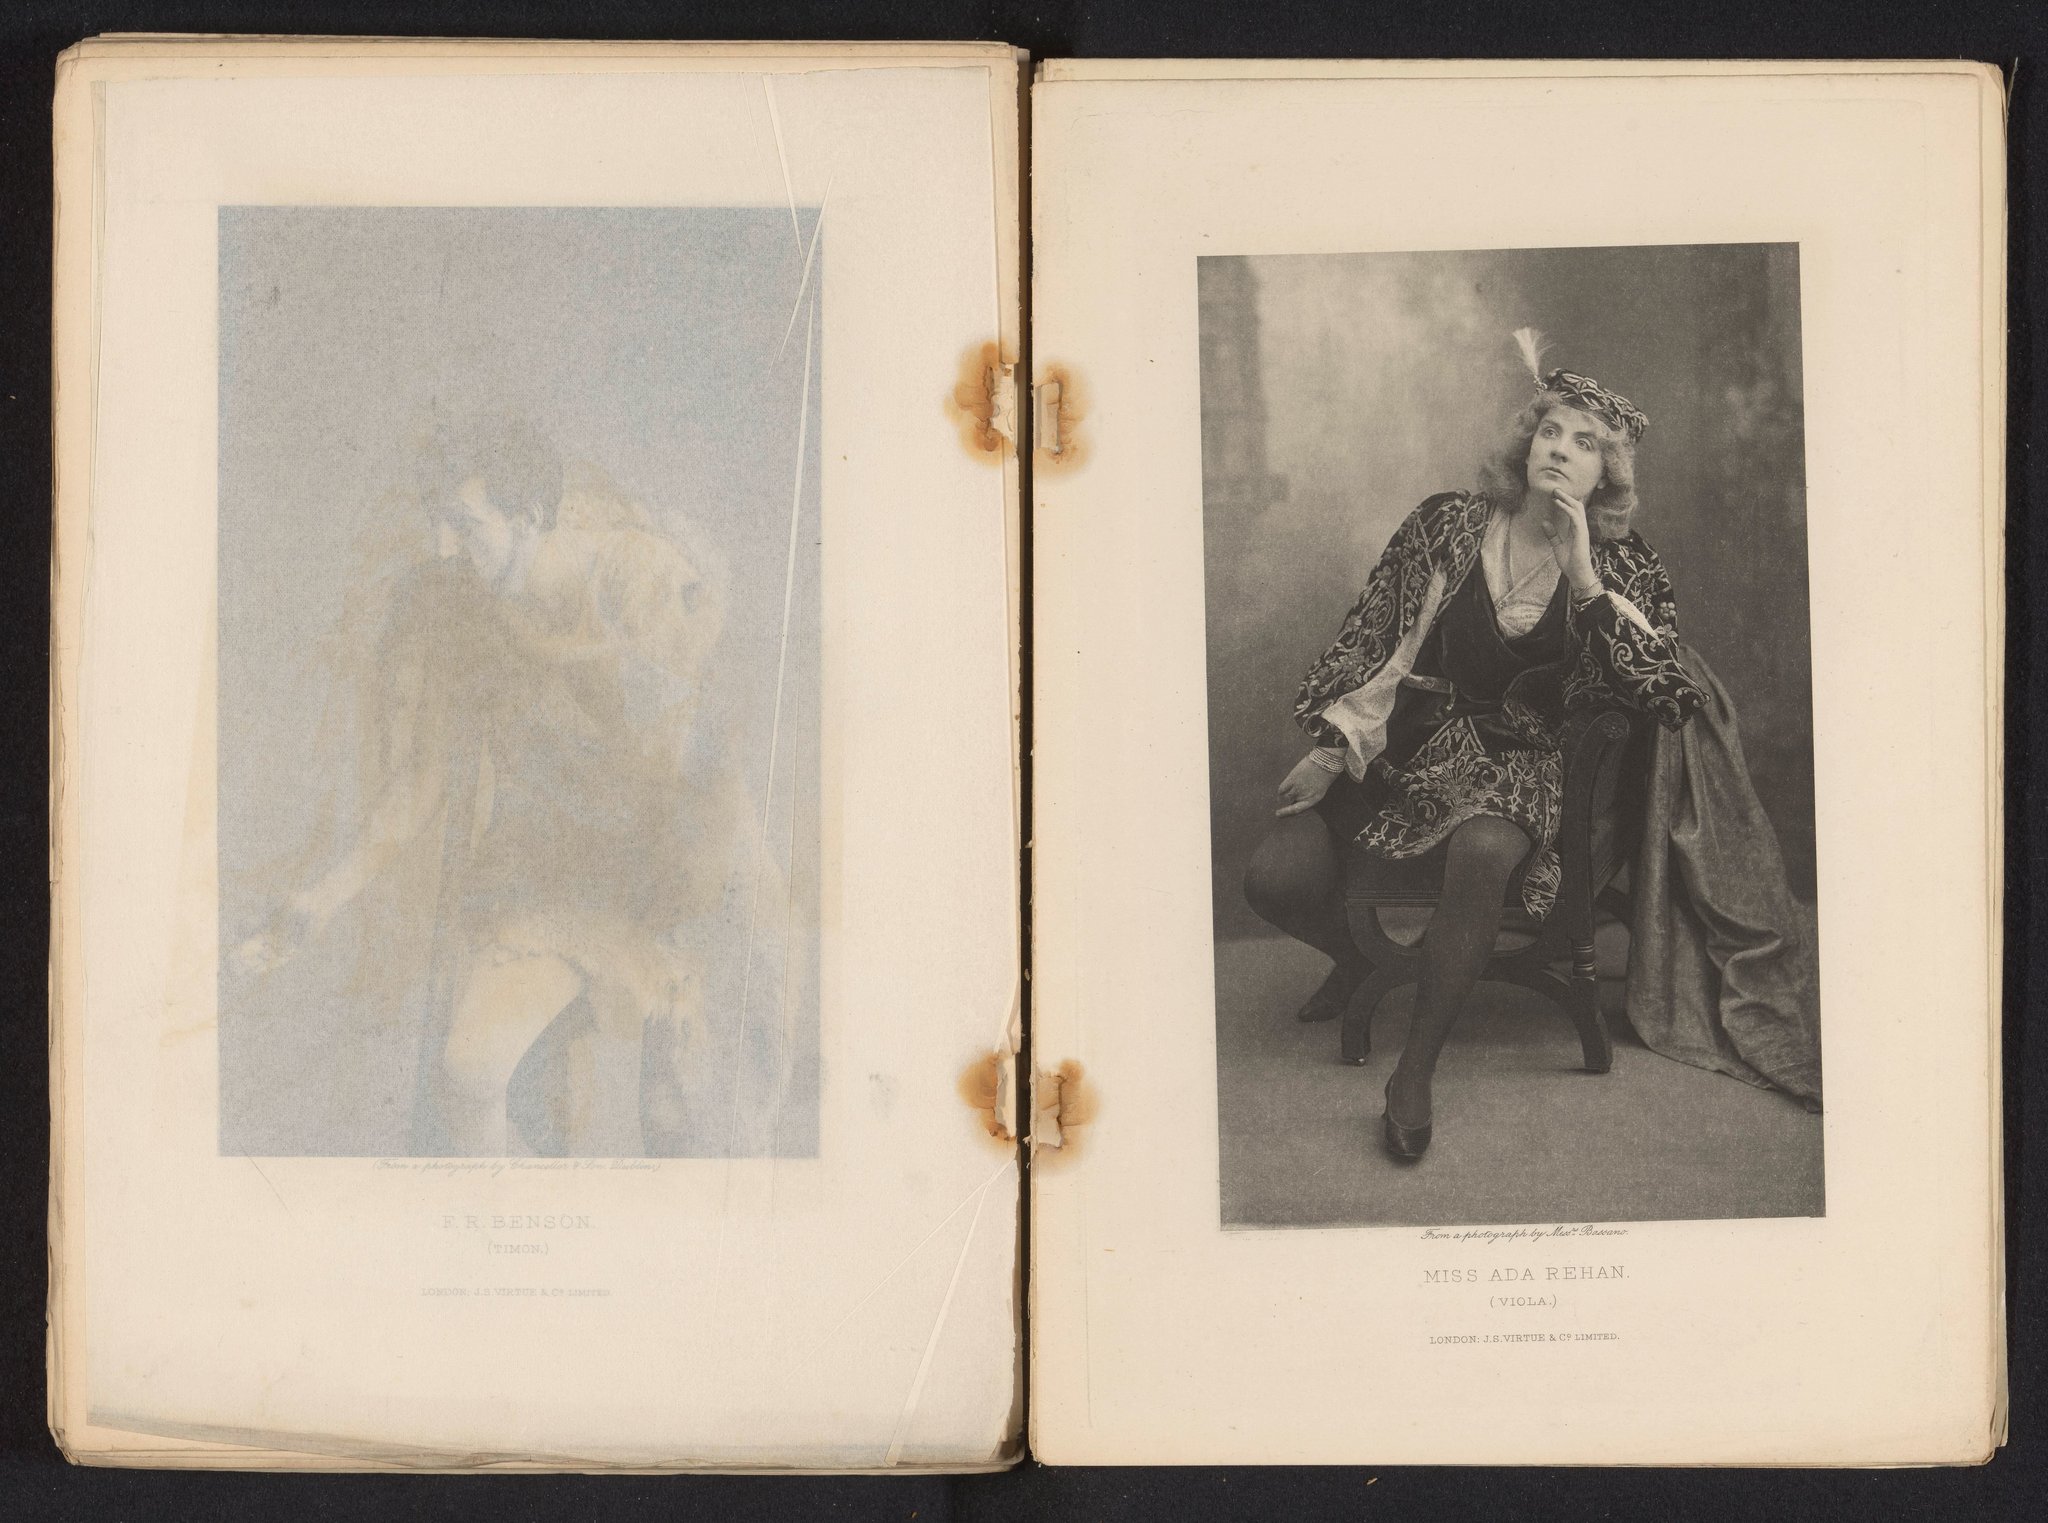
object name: photomechanical print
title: Miss Ada Rehan (Viola)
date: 1880-1890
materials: paper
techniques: photoaquatint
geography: london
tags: portrait of actor, actress